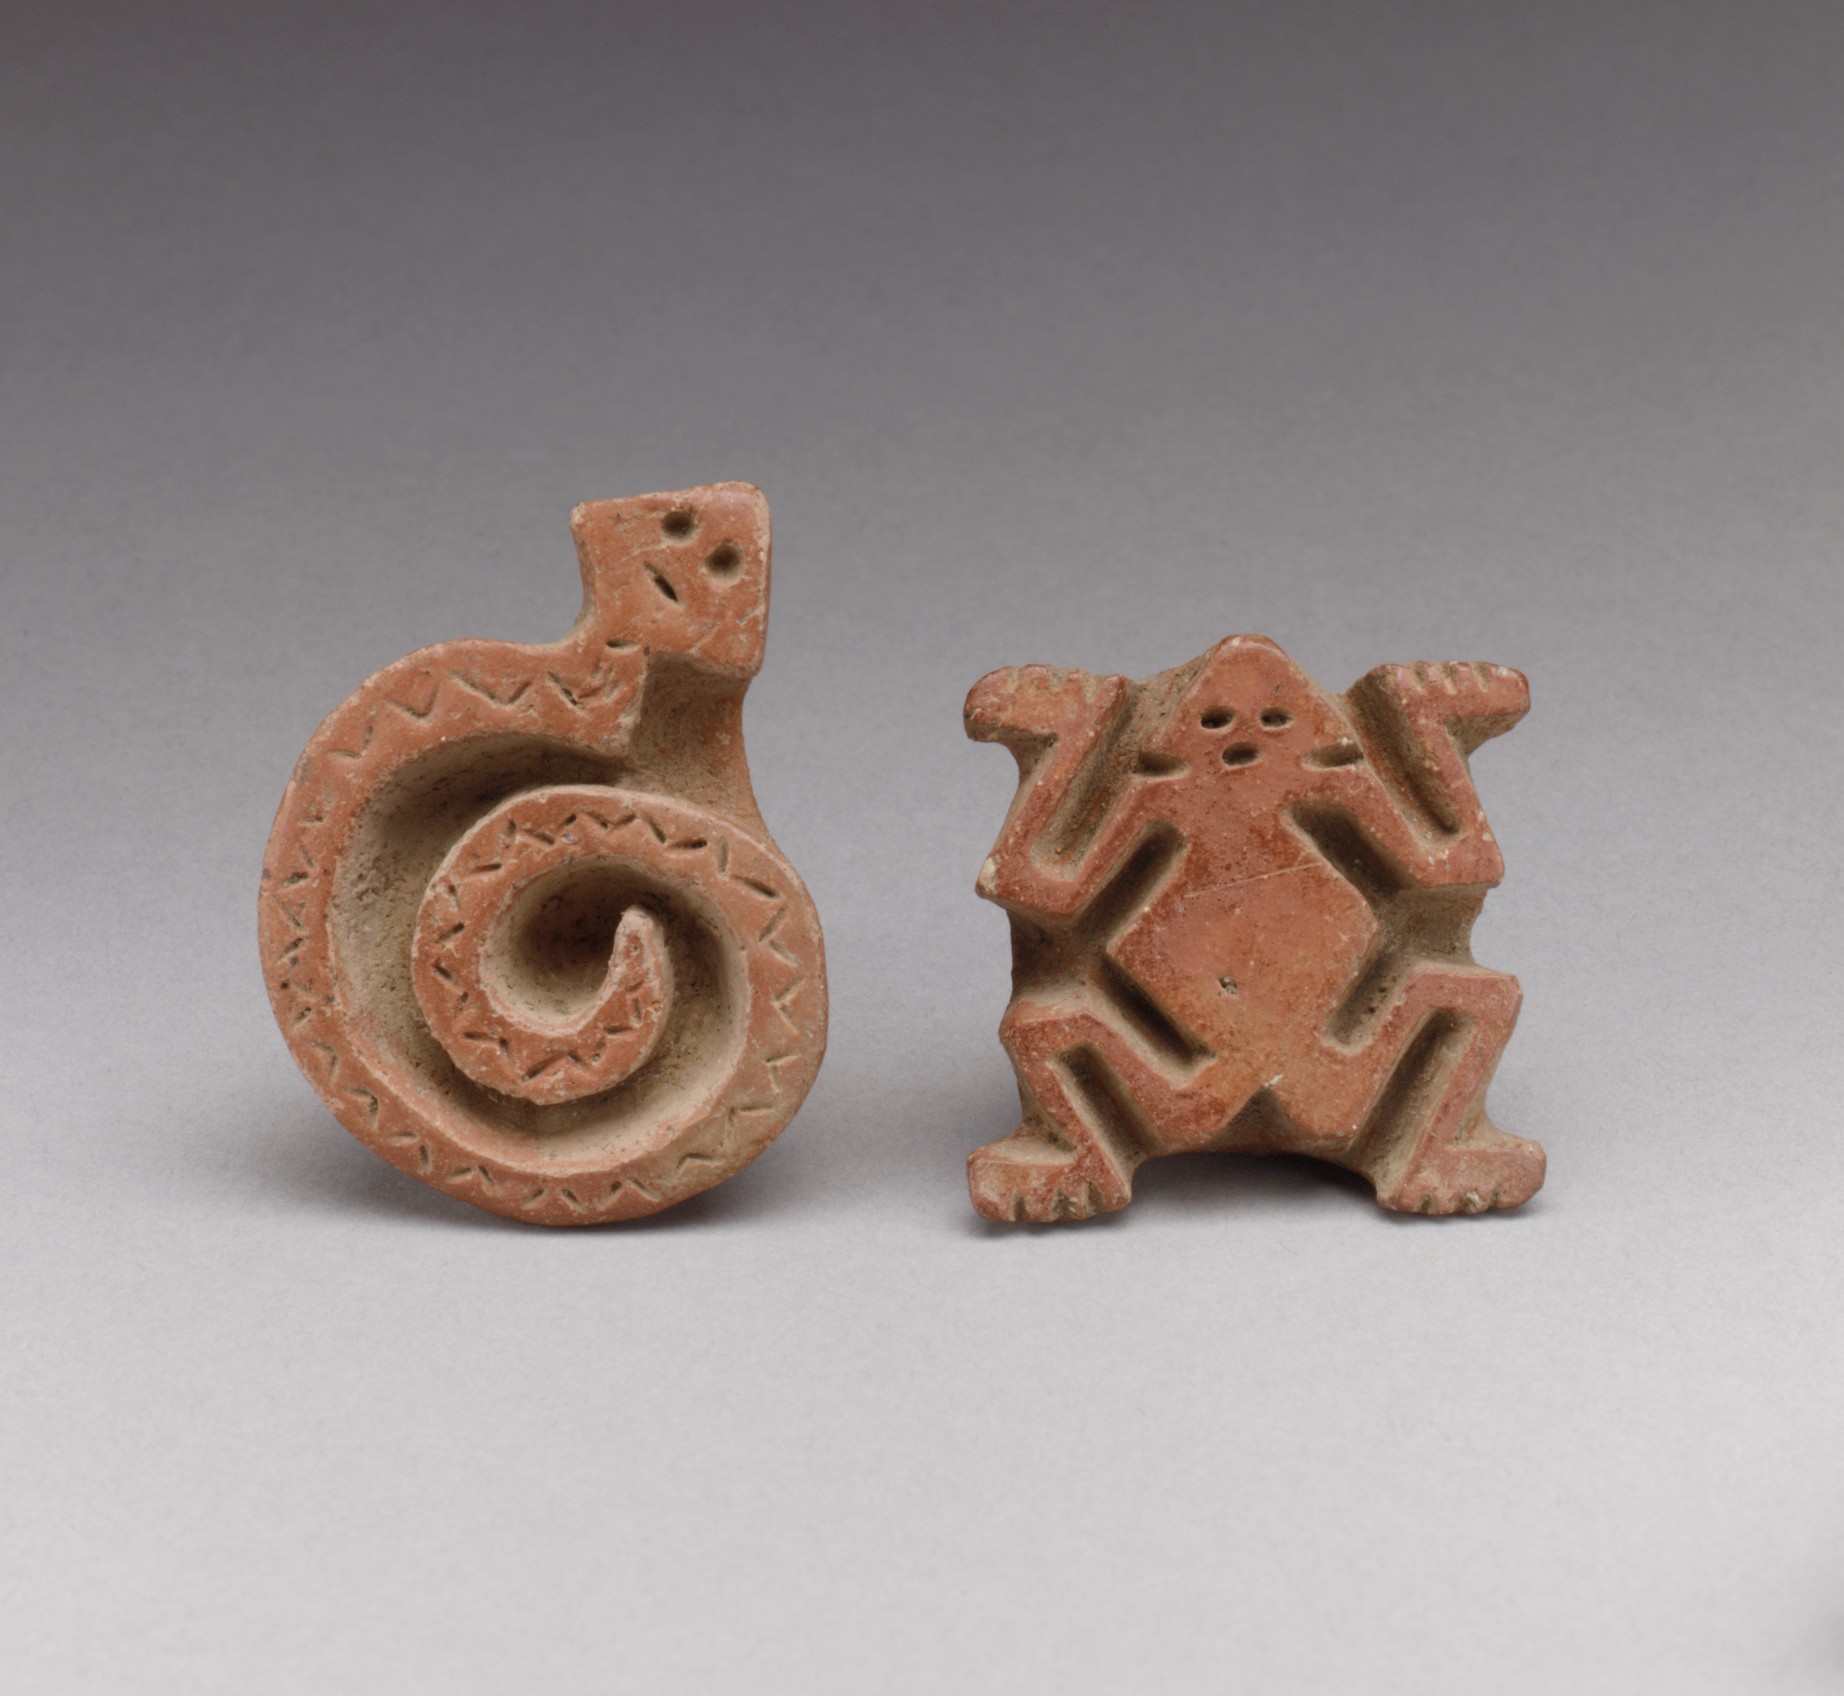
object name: stamp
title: Two Flat Stamps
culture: atlantic watershed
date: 1-700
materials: ceramic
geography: costa rica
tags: frogs,serpents